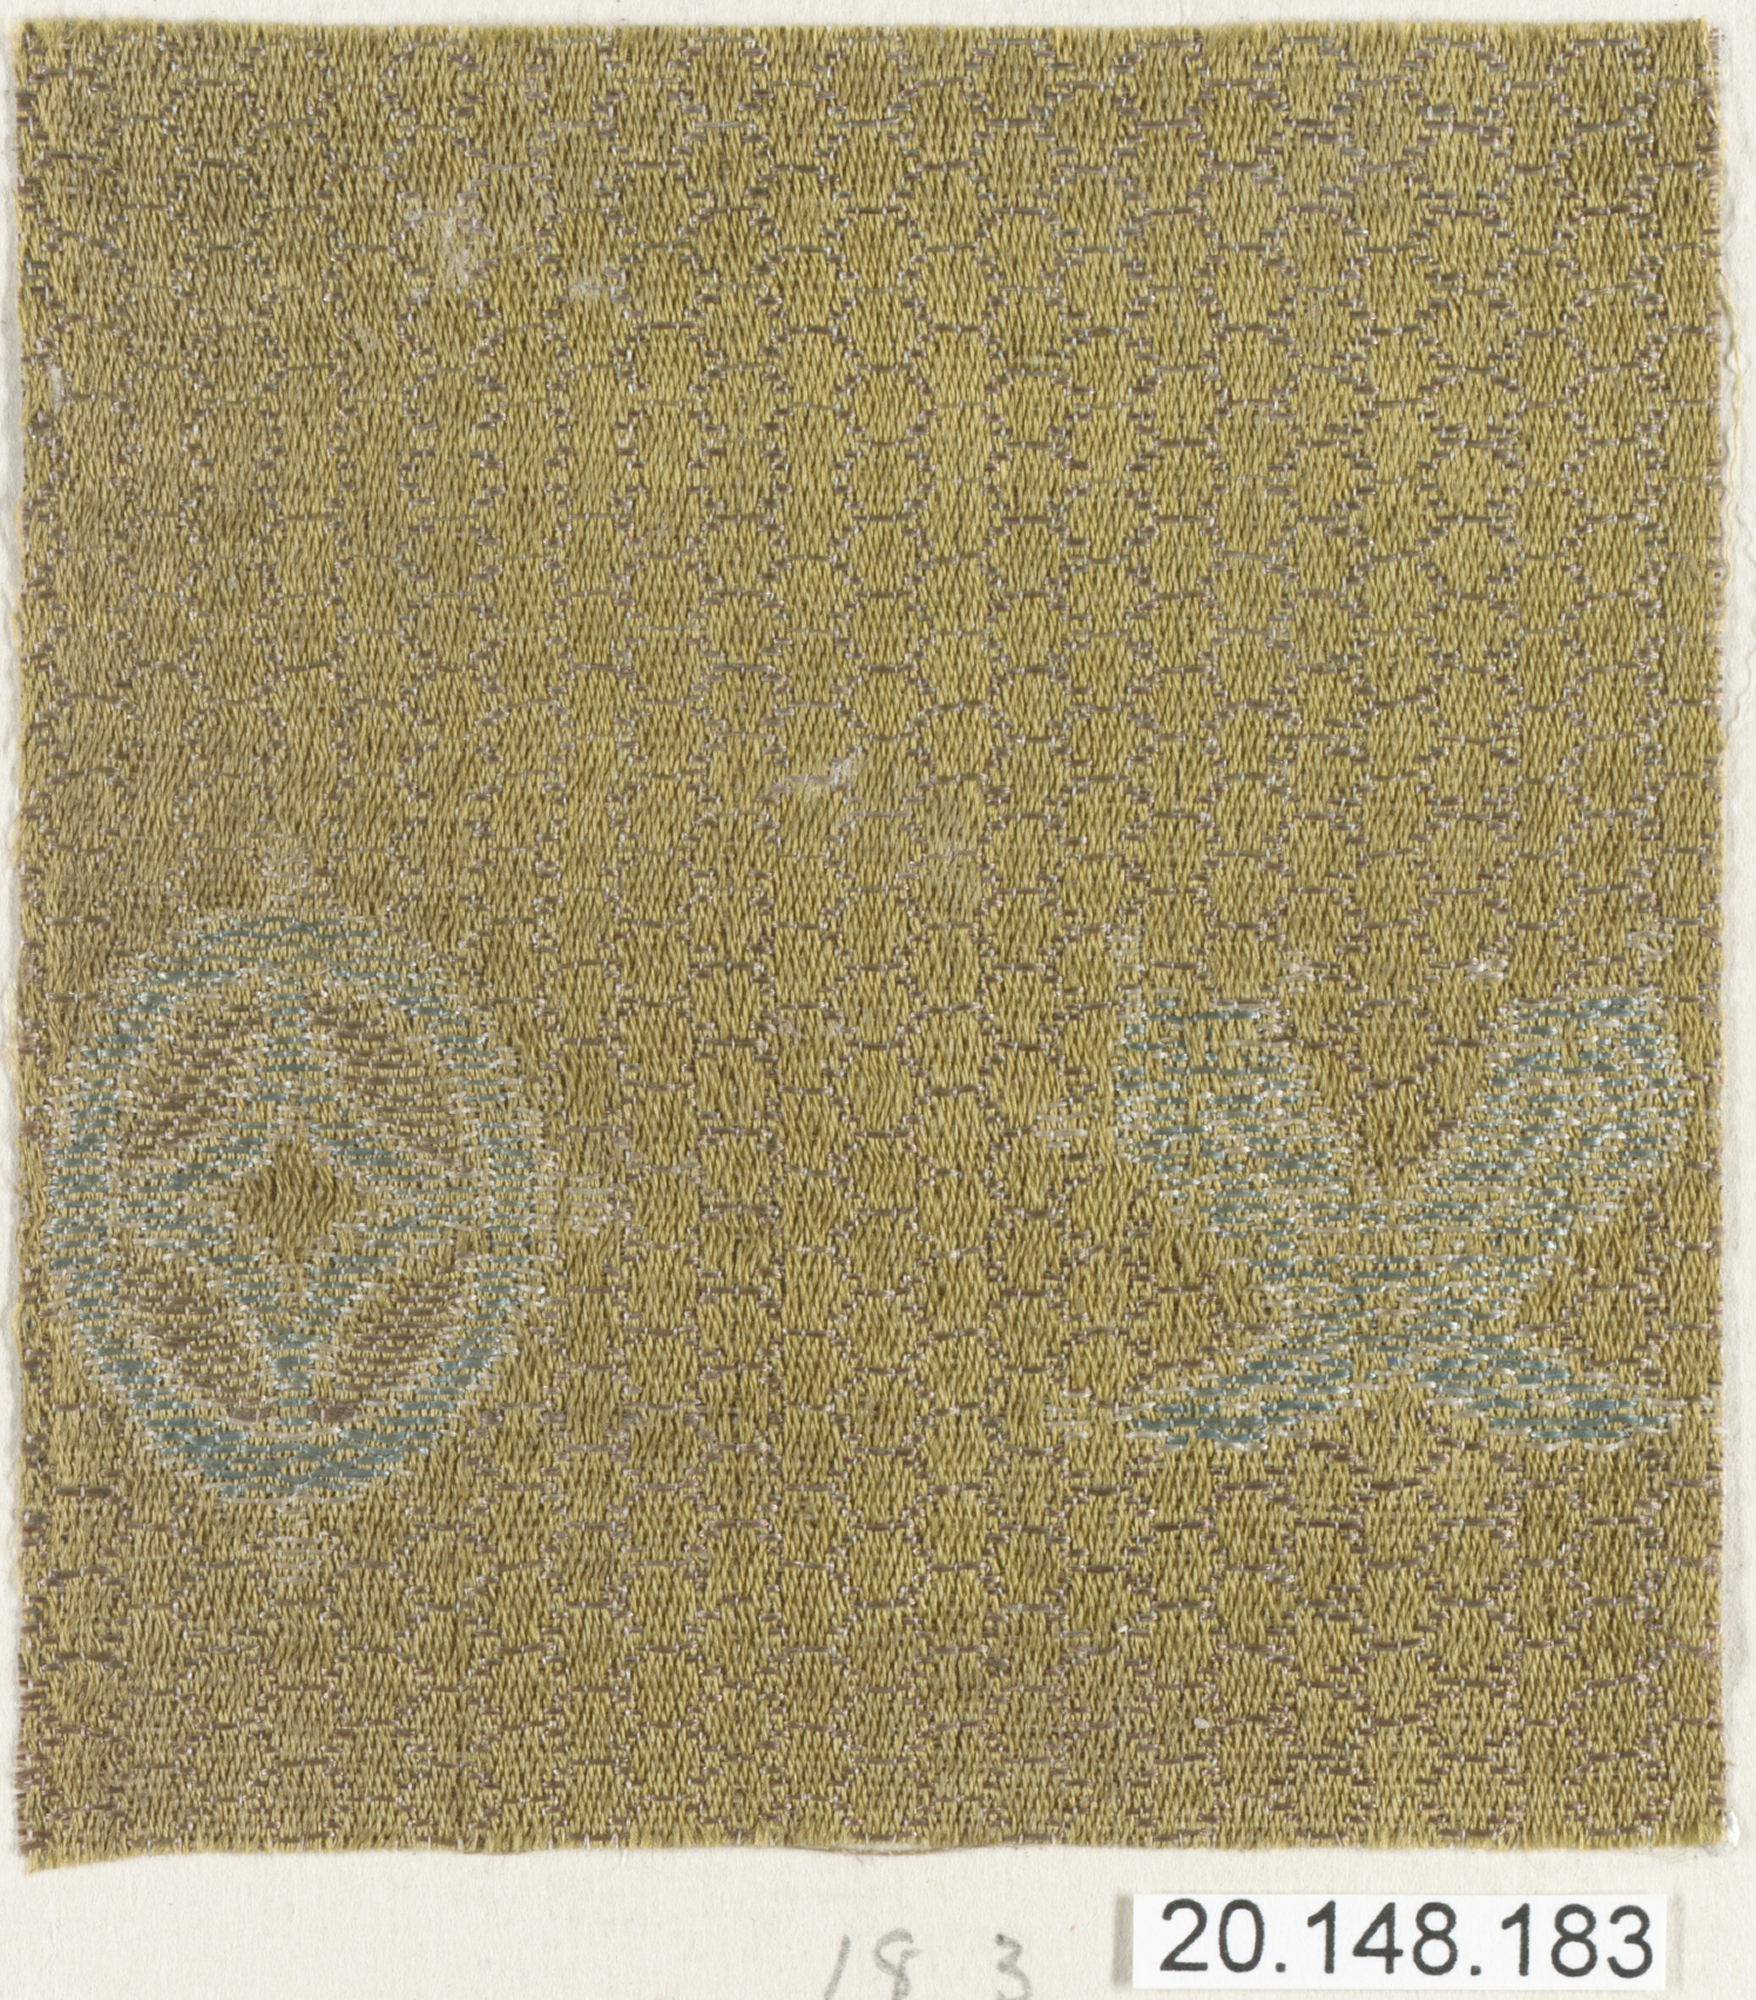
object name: piece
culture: japanese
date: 1701-1800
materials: silk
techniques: compound weave